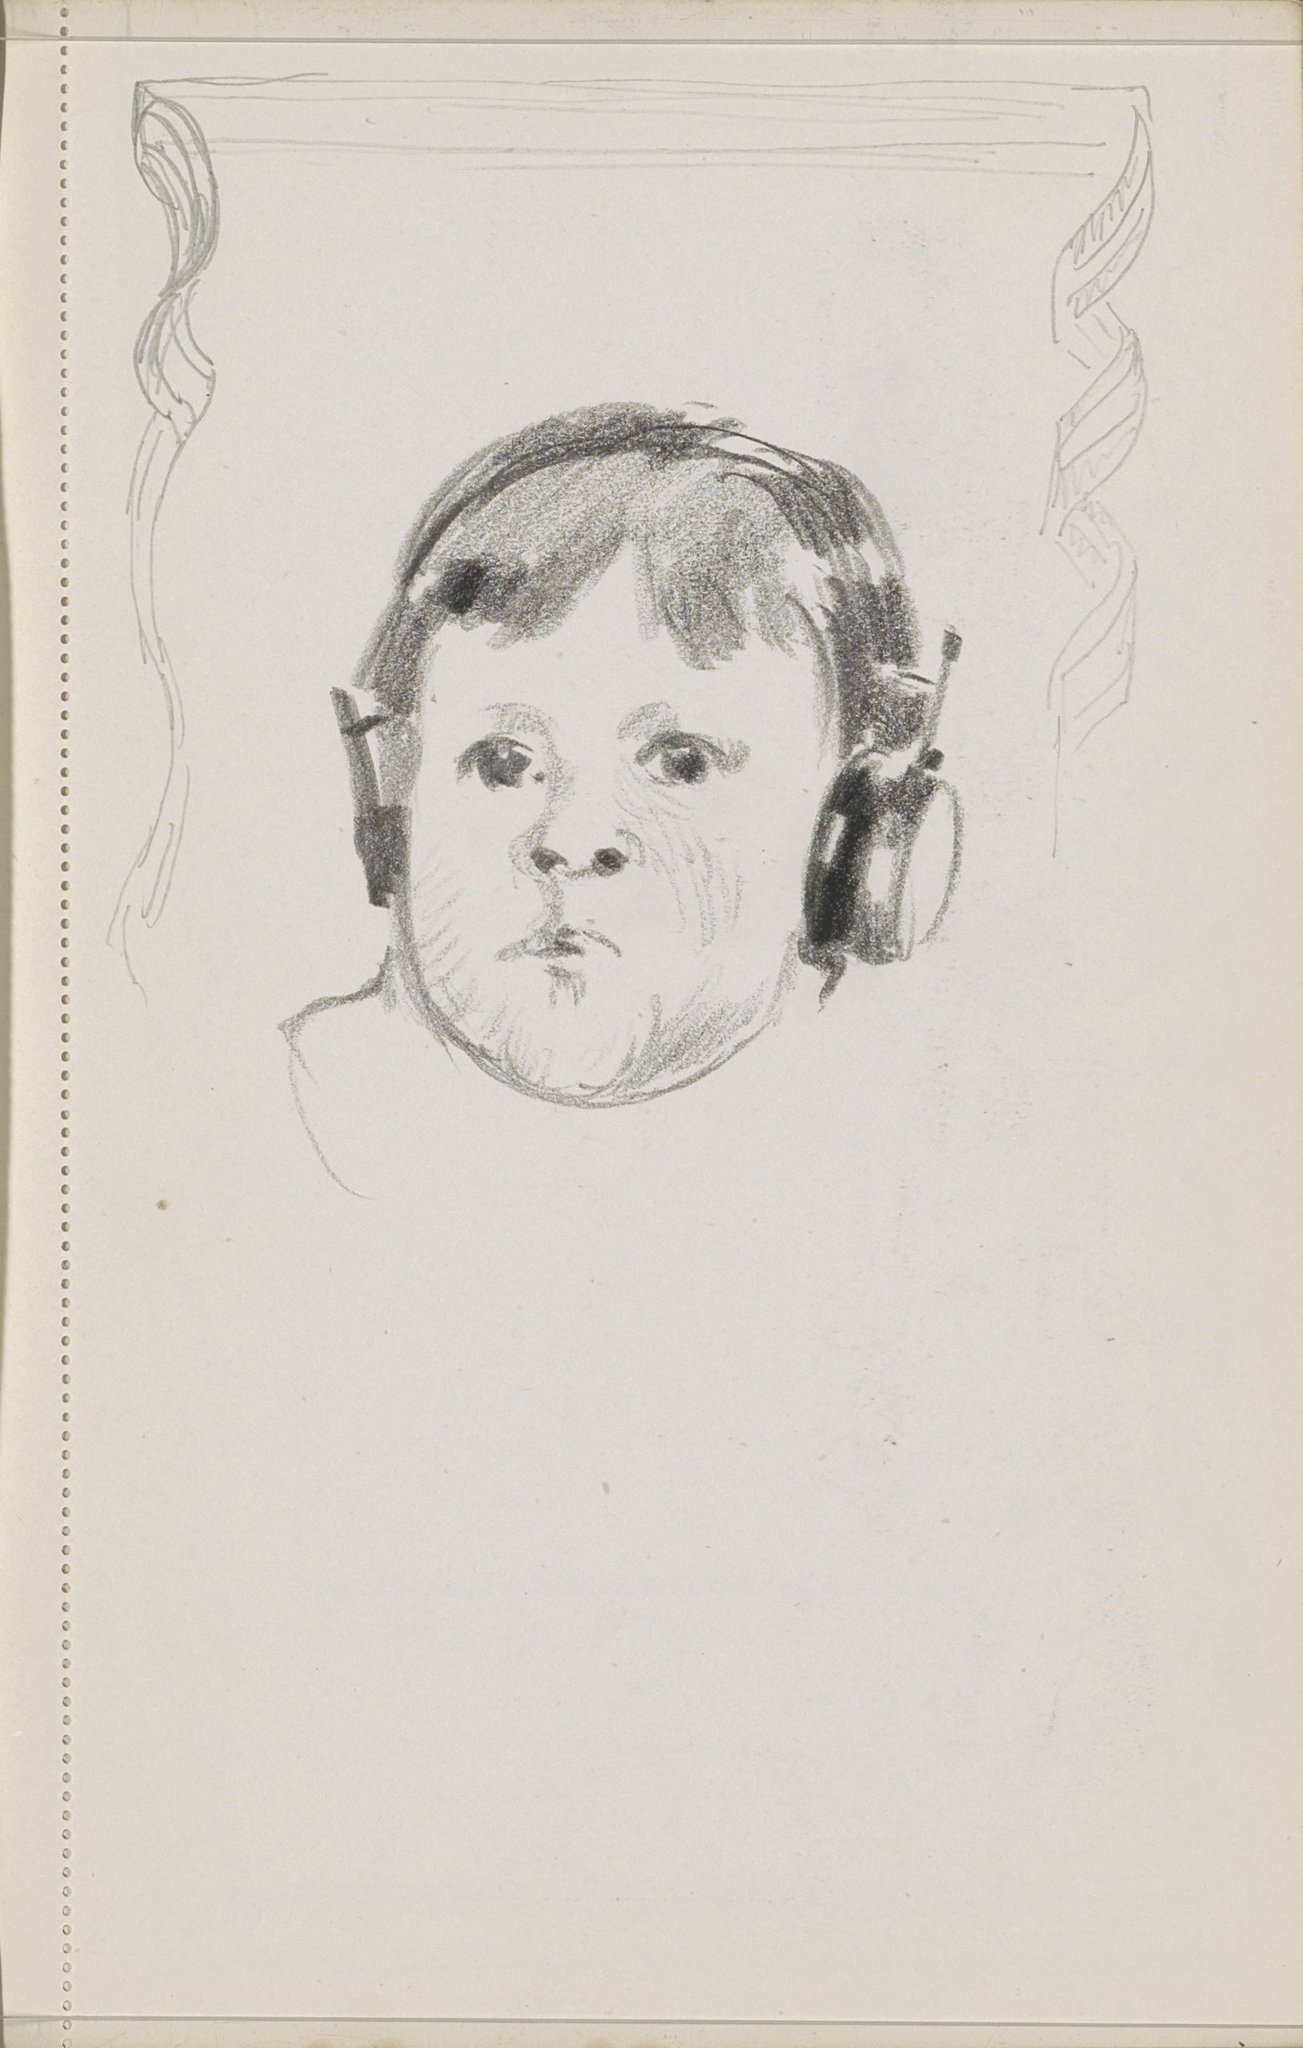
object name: sketchbook leaf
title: Portret van een kind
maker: cornelis vreedenburgh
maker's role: draughtsman, print maker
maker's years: 1880-1946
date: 1890-1946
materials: chalk, paper, pencil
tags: child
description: Blad 39 recto uit een schetsboek met 53 bladen.